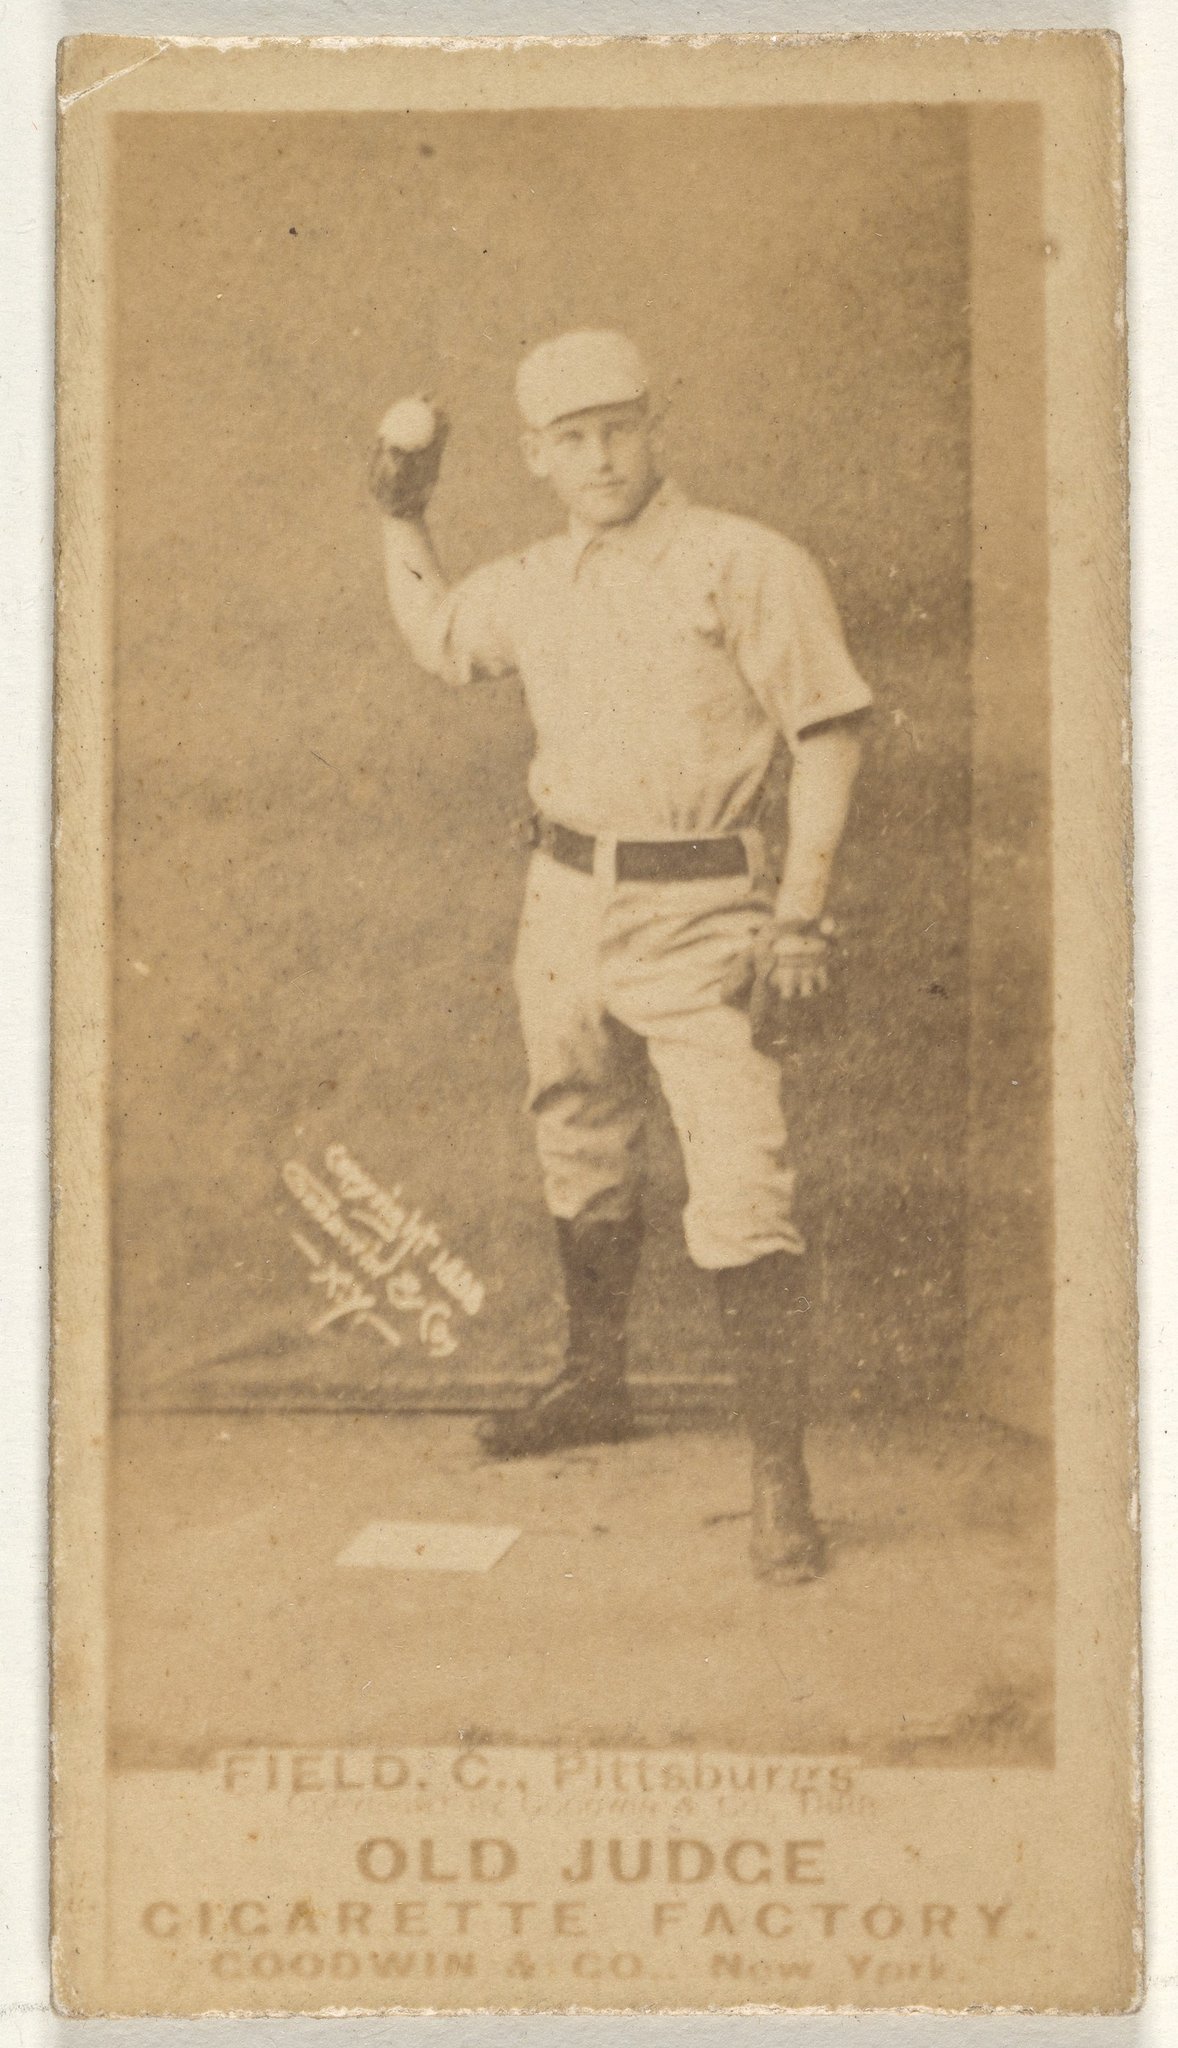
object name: baseball card, photograph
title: John Joseph "Jocko" Fields, Catcher, Pittsburgh, from the Old Judge series (N172) for Old Judge Cigarettes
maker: goodwin & company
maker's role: publisher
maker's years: 1850-1950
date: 1888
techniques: albumen silver print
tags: men,portraits,baseball,athletes